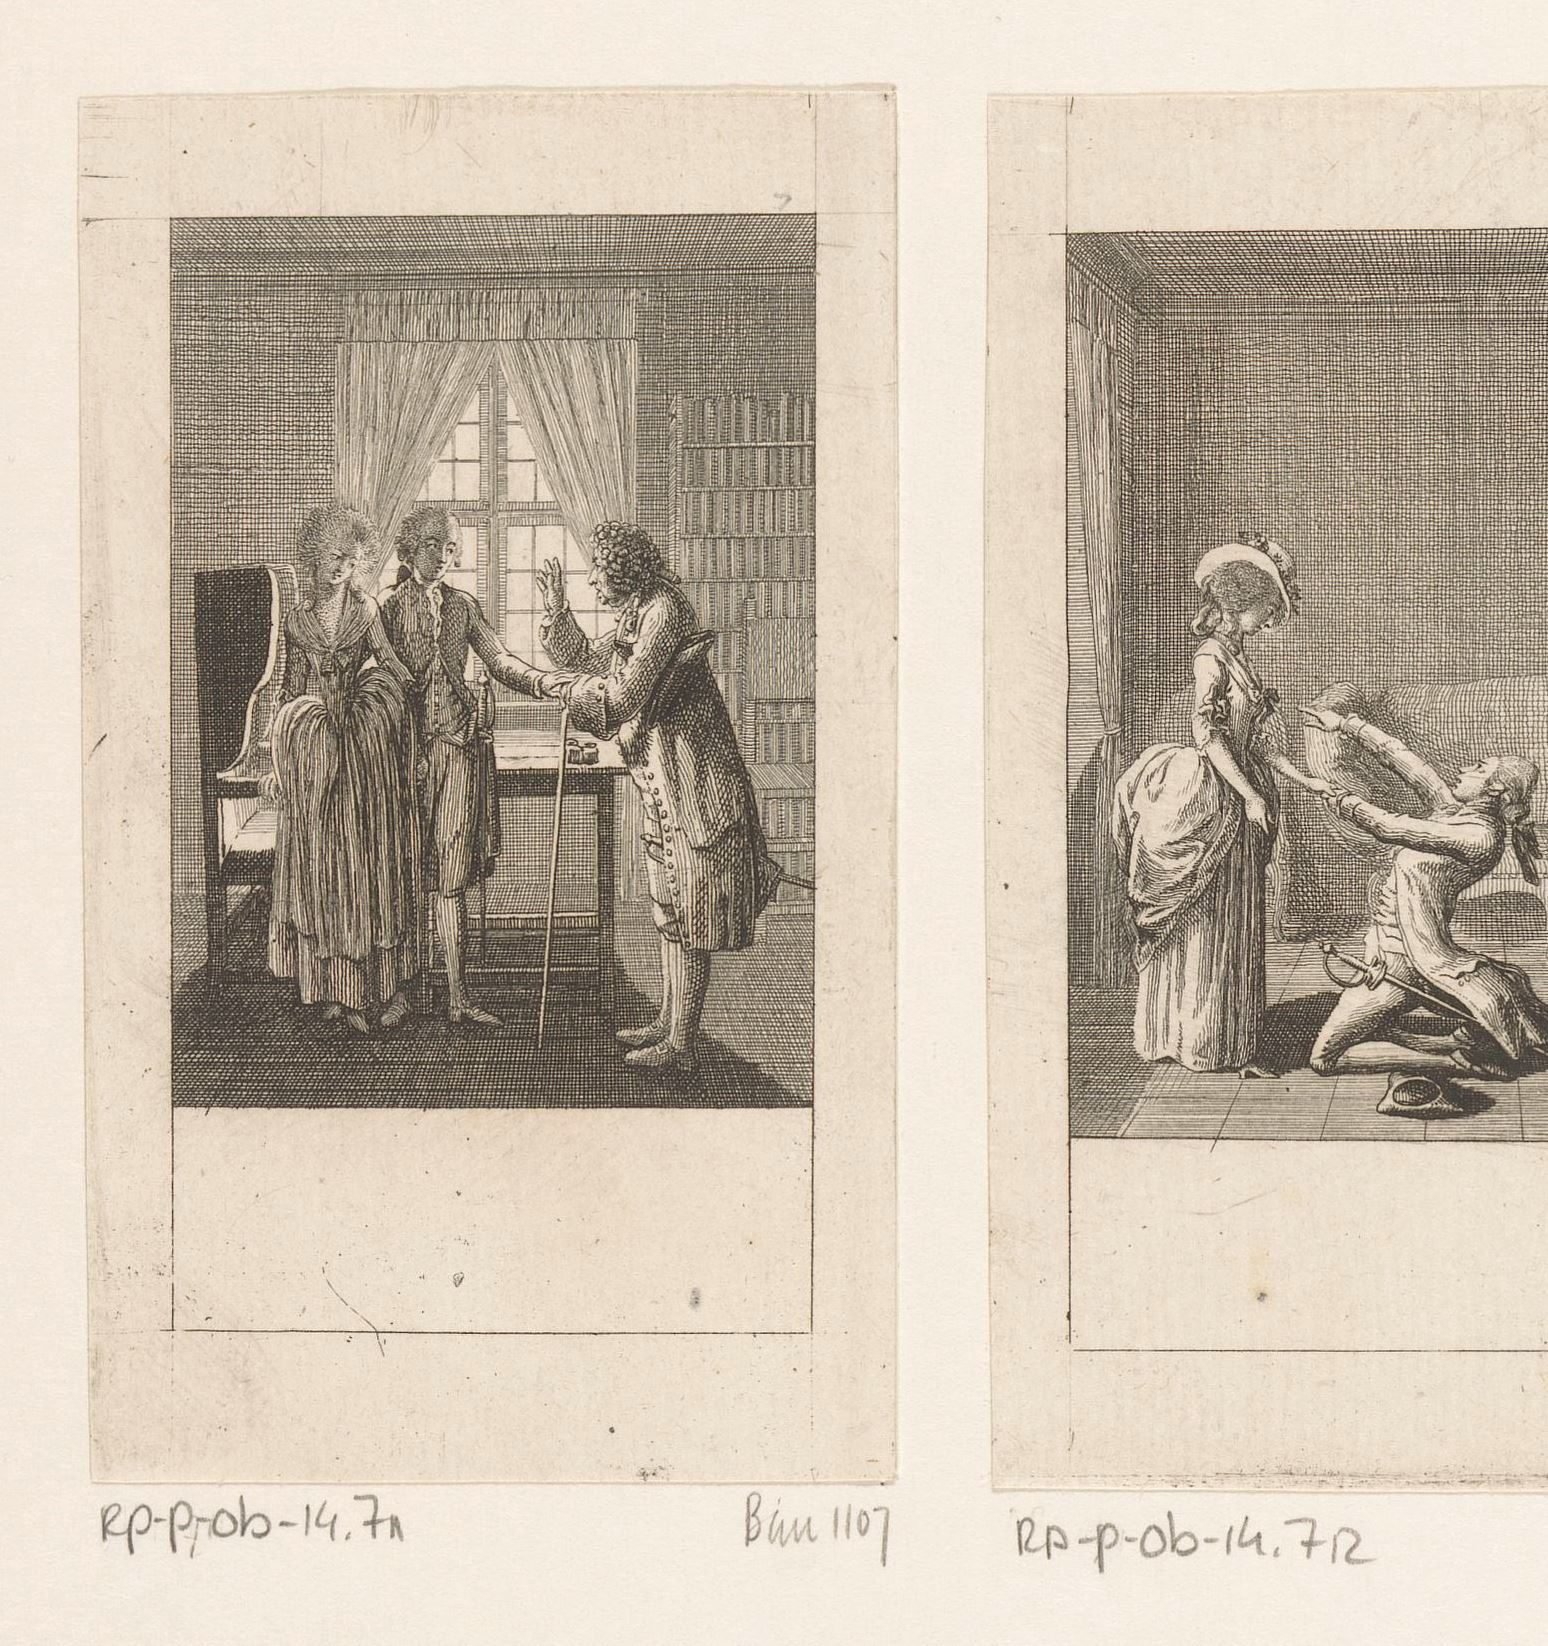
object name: print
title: Wilhelm Esch en Julie vragen Storr hen te huwen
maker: daniel nikolaus chodowiecki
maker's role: draughtsman, print maker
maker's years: 1726-1801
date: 1784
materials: paper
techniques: etching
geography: berlin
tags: literature, betrothal and marriage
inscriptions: collector's mark: Lugt 2228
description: Vervaardigd voor Christian Friedrich Bretzners 'Eheprocurator'. Latere staat gebruikt voor: Konigl. Grosbrit. Genealogischen Kalender auf das Jahr 1785. Lauenburg: J. G. Berenberg, 1784.